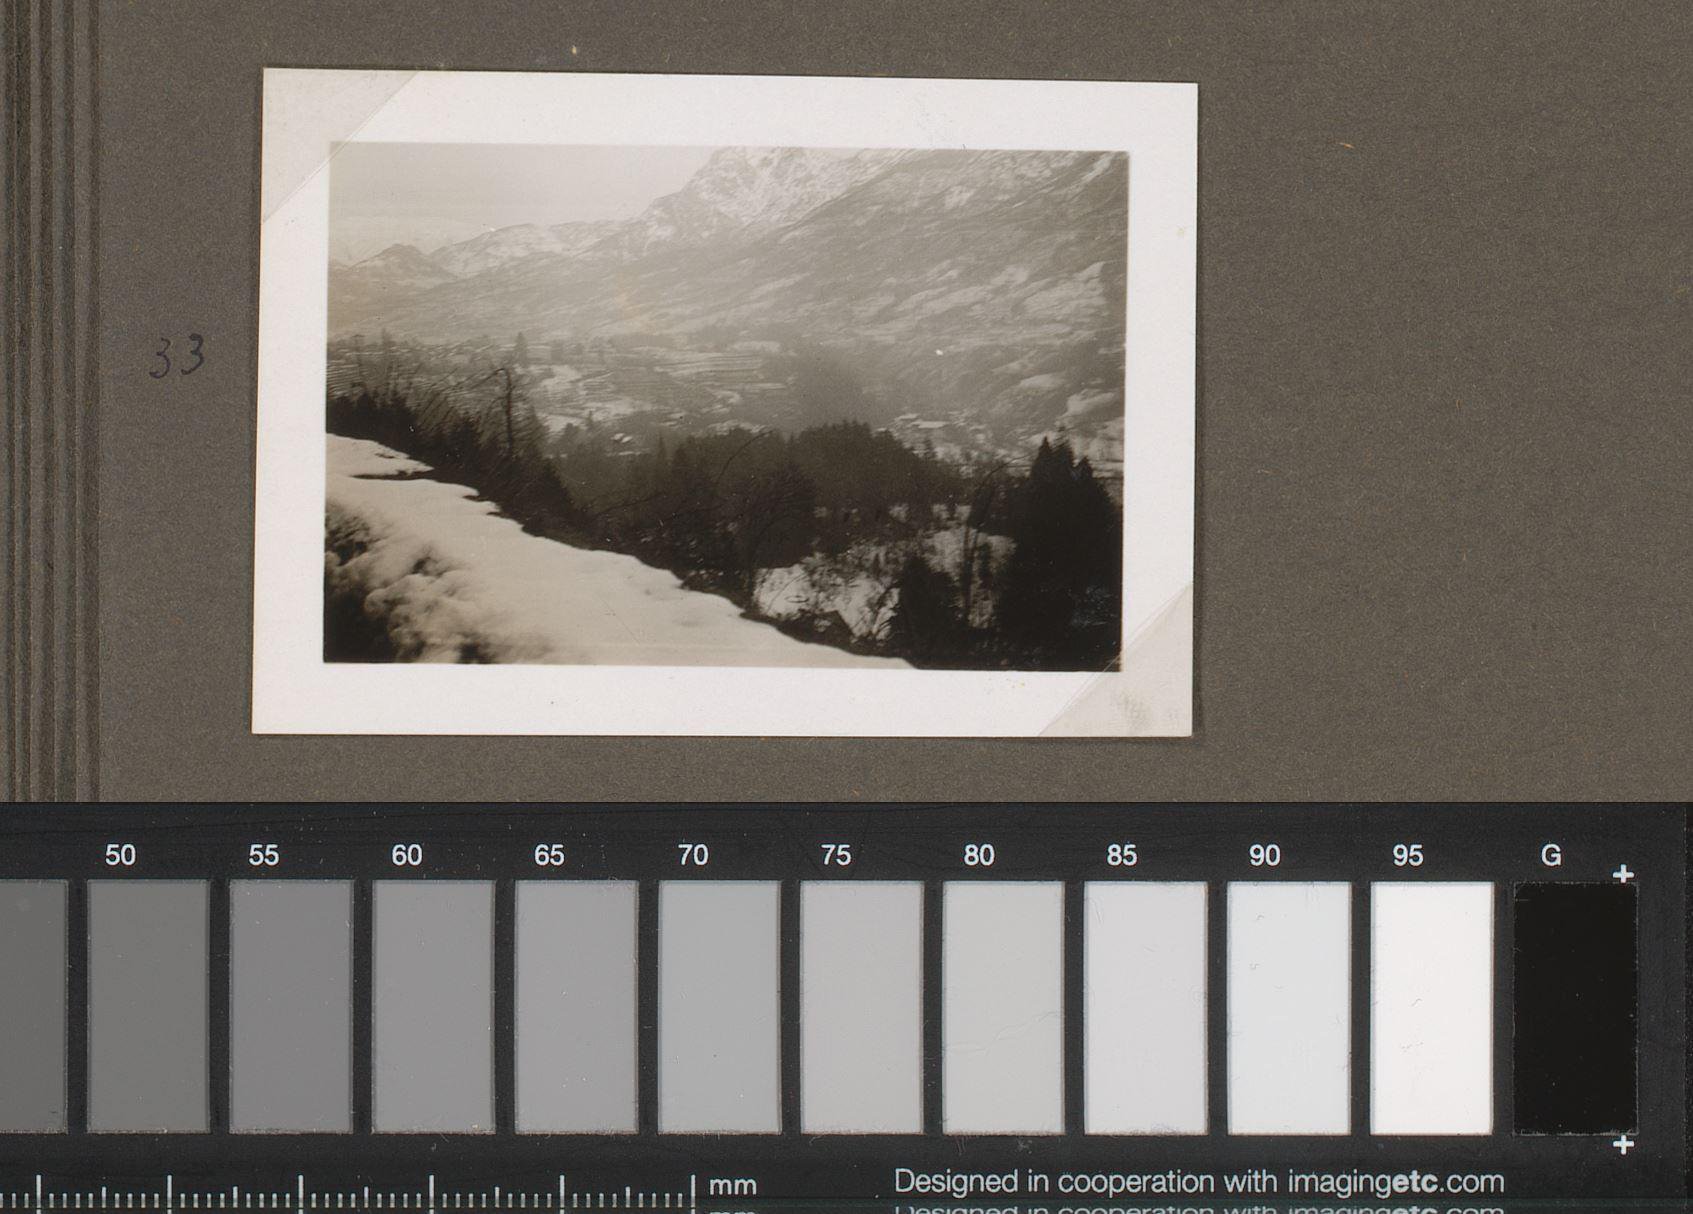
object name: photograph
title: Gezicht op een vallei tussen Vira en Tesserete, Zwitserland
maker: Anonymous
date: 1934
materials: photographic support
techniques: gelatin silver print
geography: ticino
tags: dale, valley, snow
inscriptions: number: ‘32’